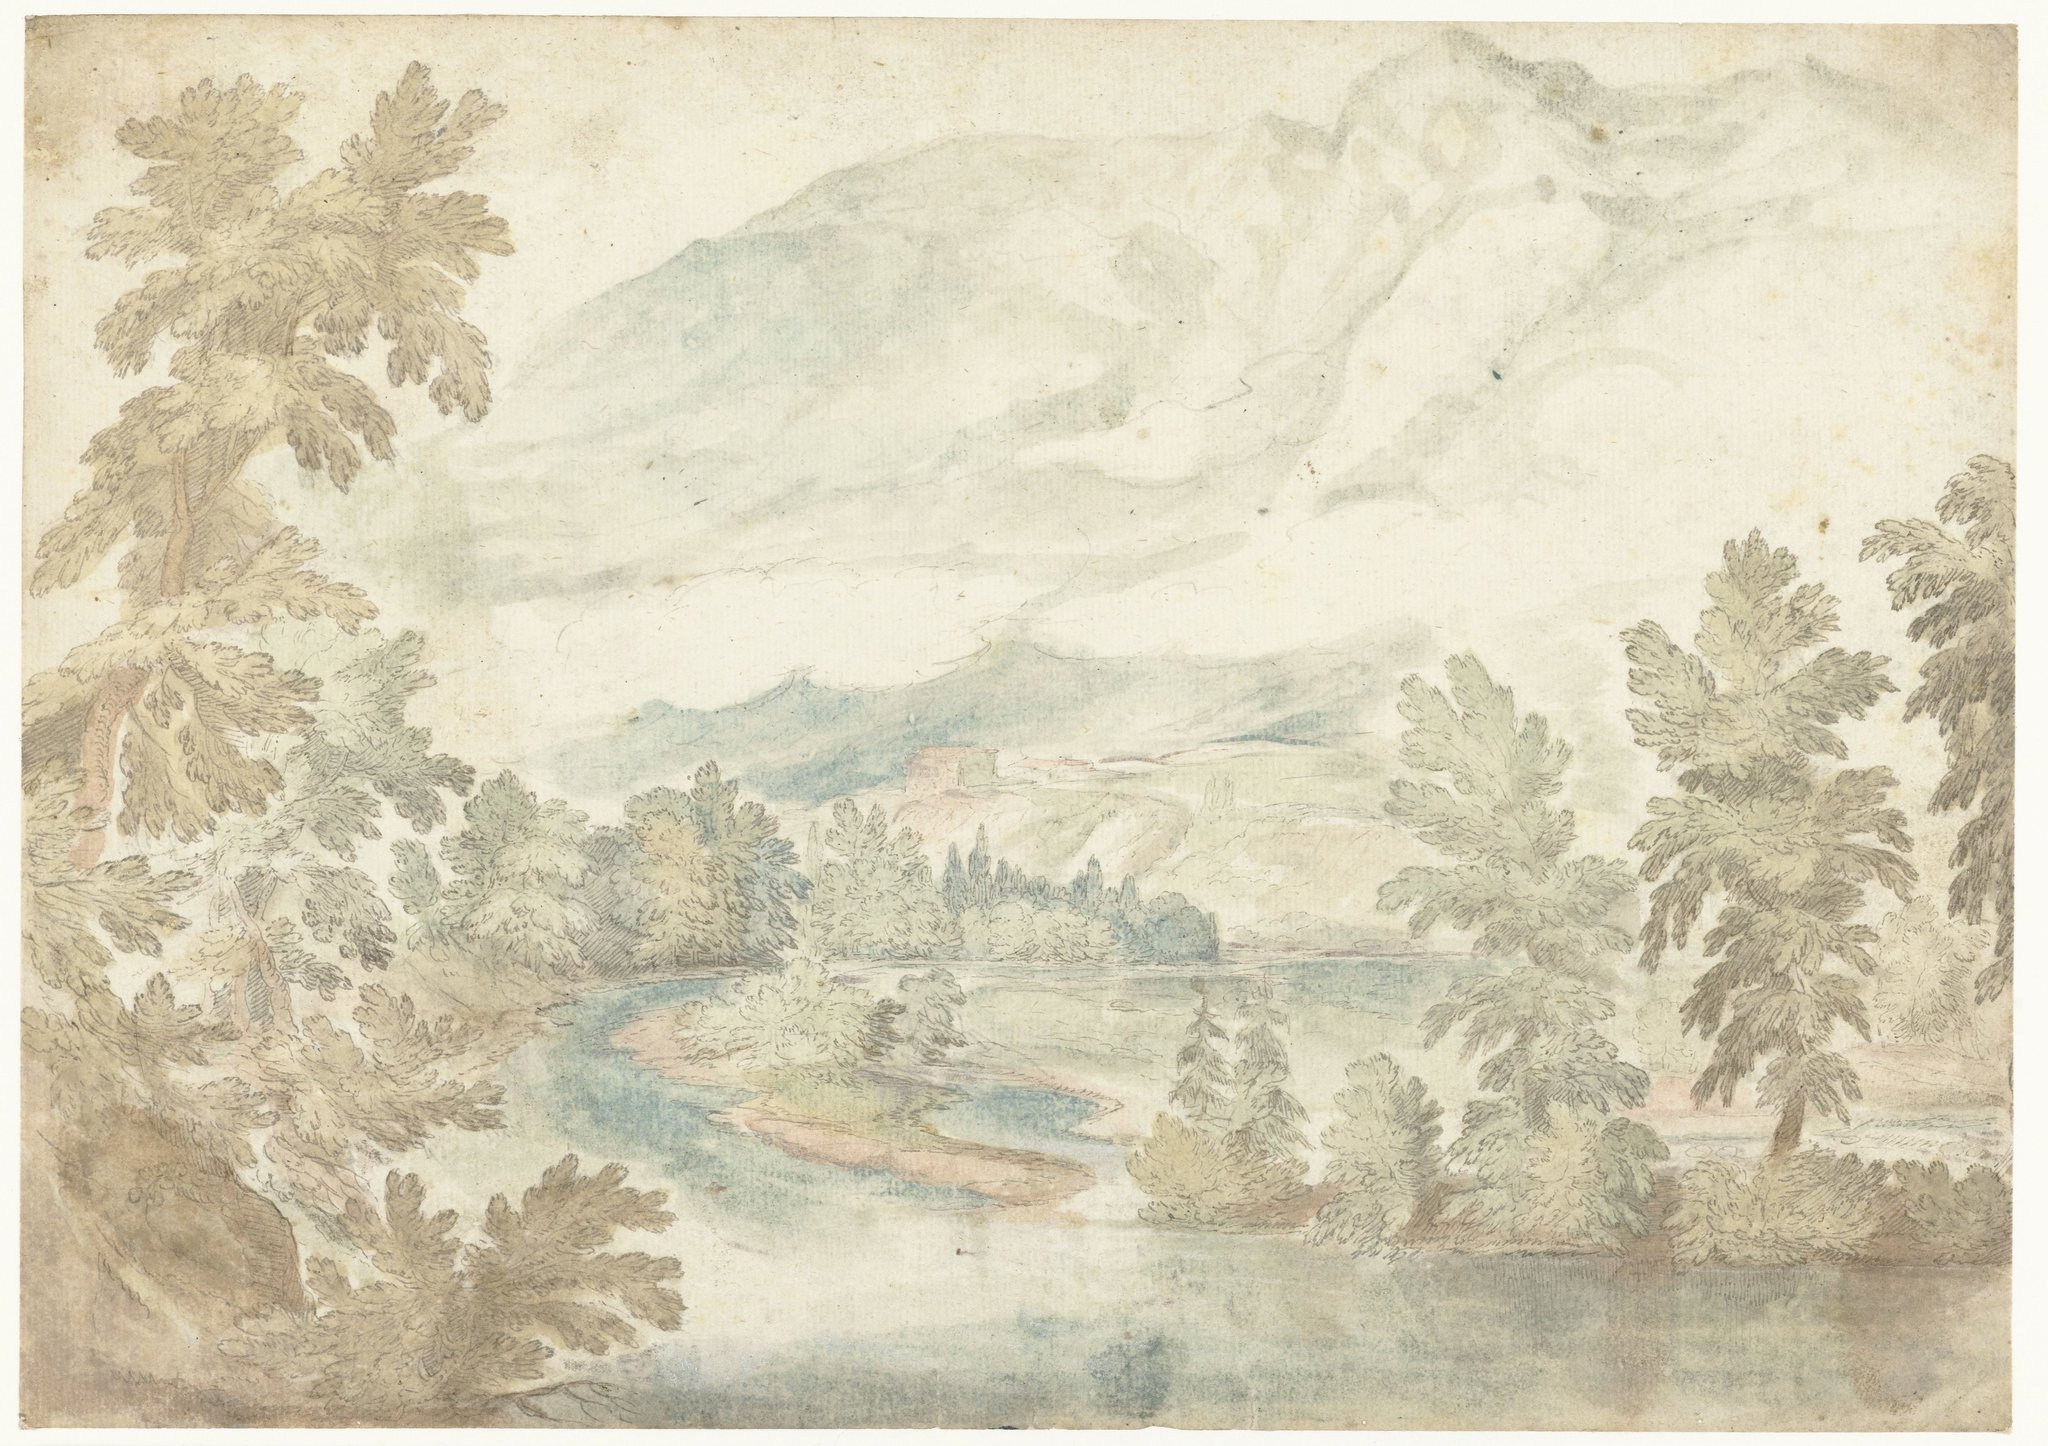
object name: drawing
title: Bocht in een rivier stromend door een dal met hoge bergen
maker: frederik van valckenborch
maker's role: draughtsman, painter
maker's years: 1566-1623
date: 1598-1599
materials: ink, paper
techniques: brush, pen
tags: river, forest, wood, mountains